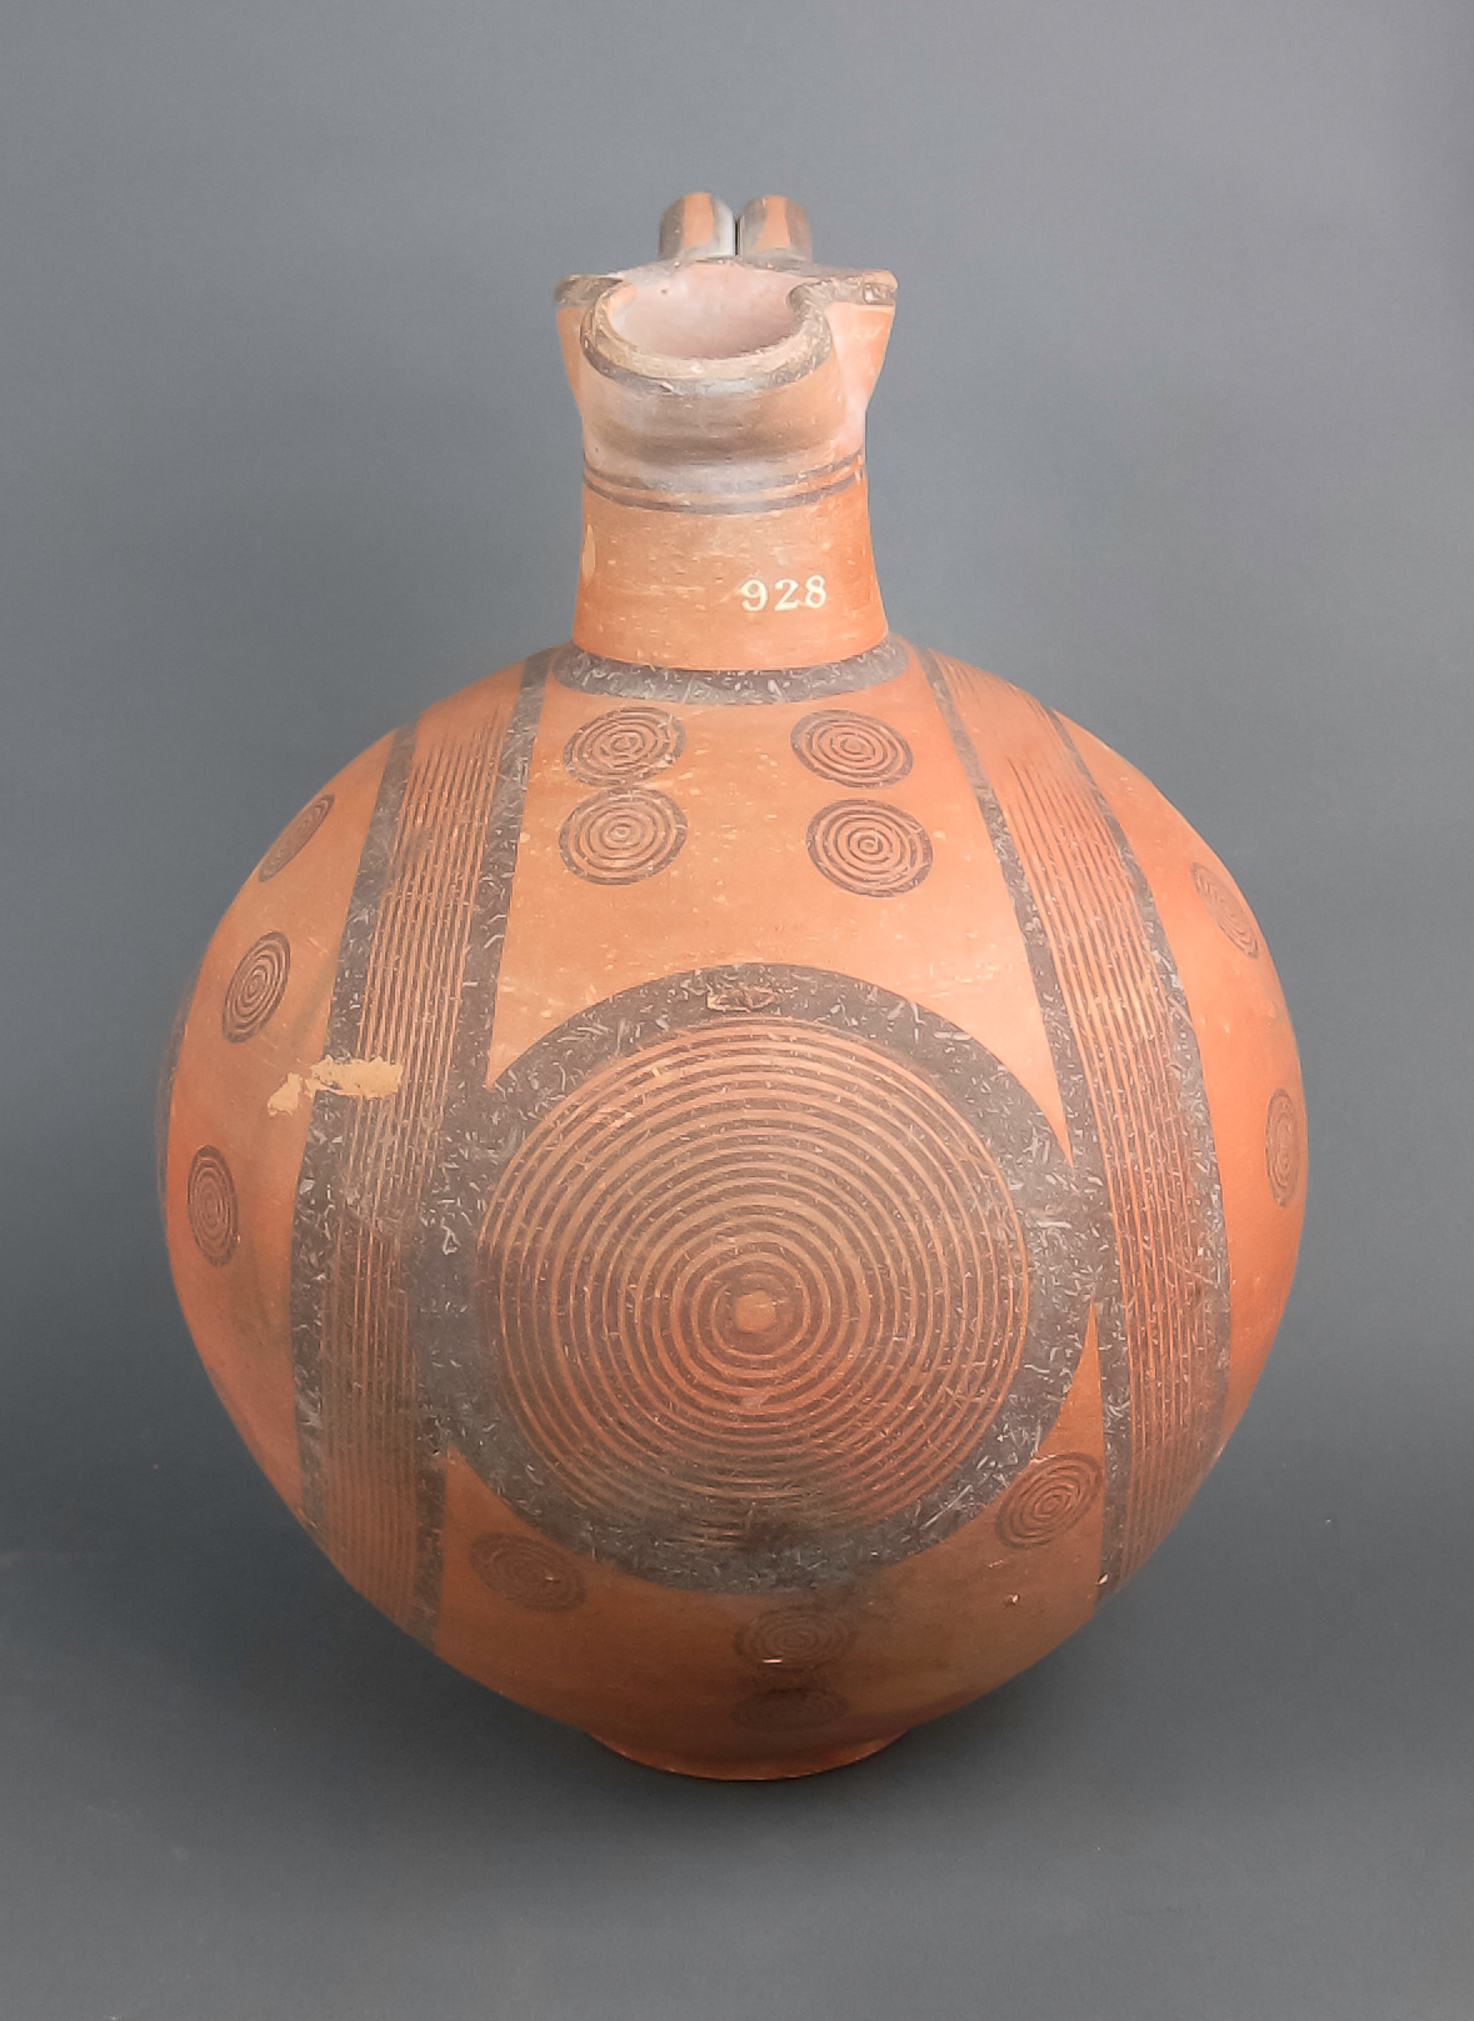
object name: oinochoe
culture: cypriot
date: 507-323 BCE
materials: terracotta